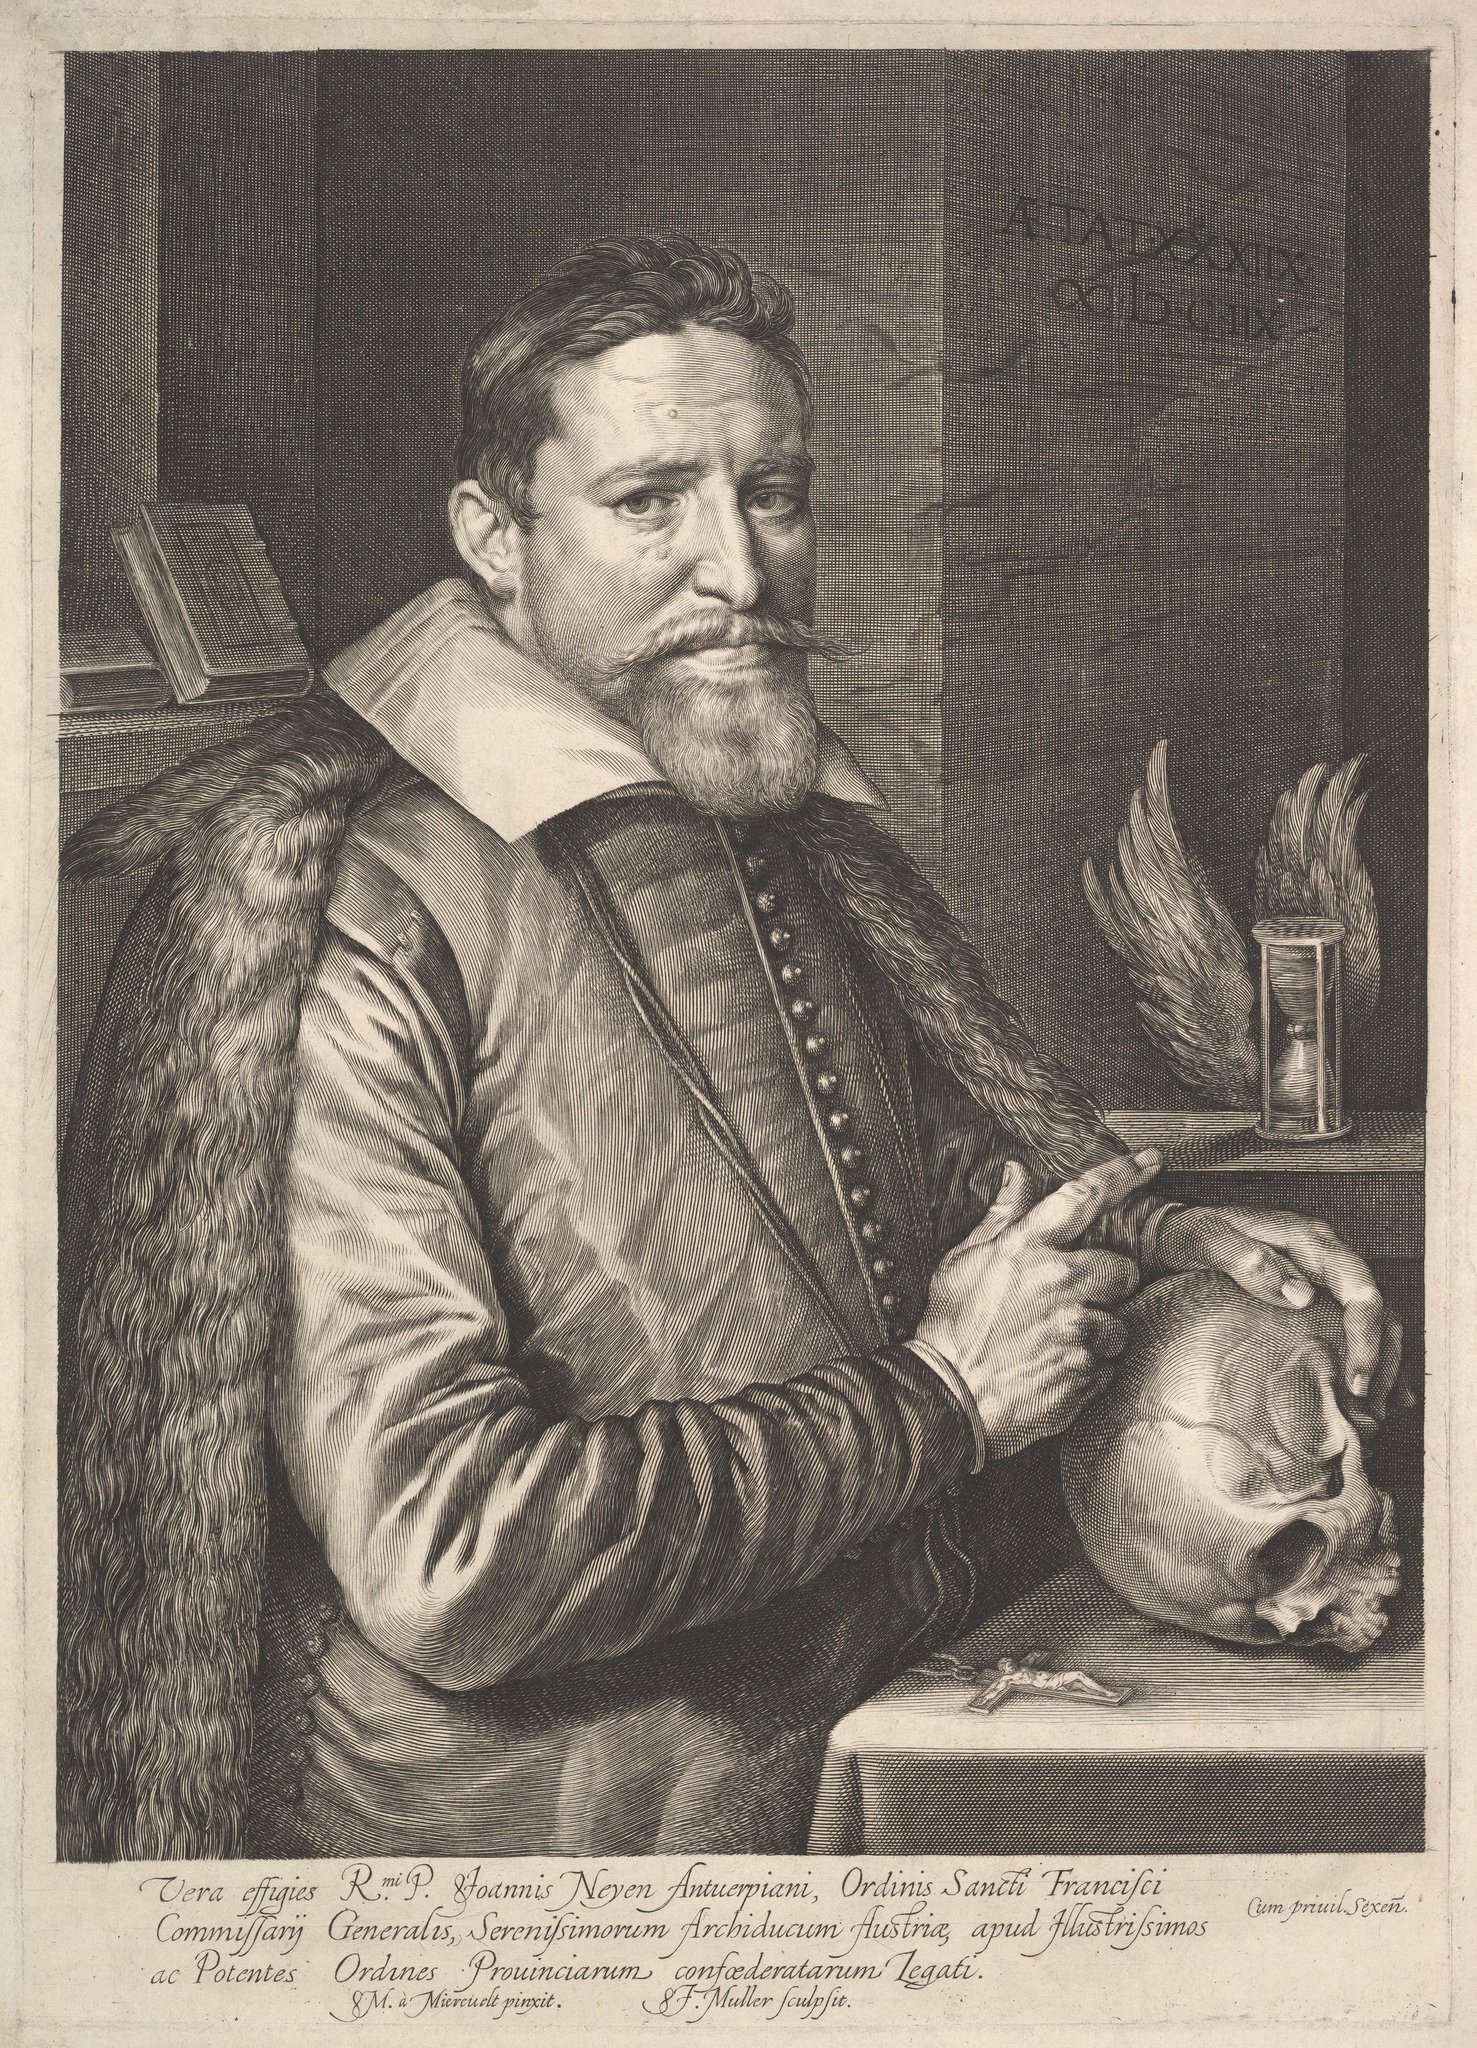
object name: print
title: Portrait of Joannes Neyen, General of the Order of Franciscan Friars, Ambassador in Trier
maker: jan muller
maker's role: artist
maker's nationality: netherlandish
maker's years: 1571-1628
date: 1608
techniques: engraving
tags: portraits,women